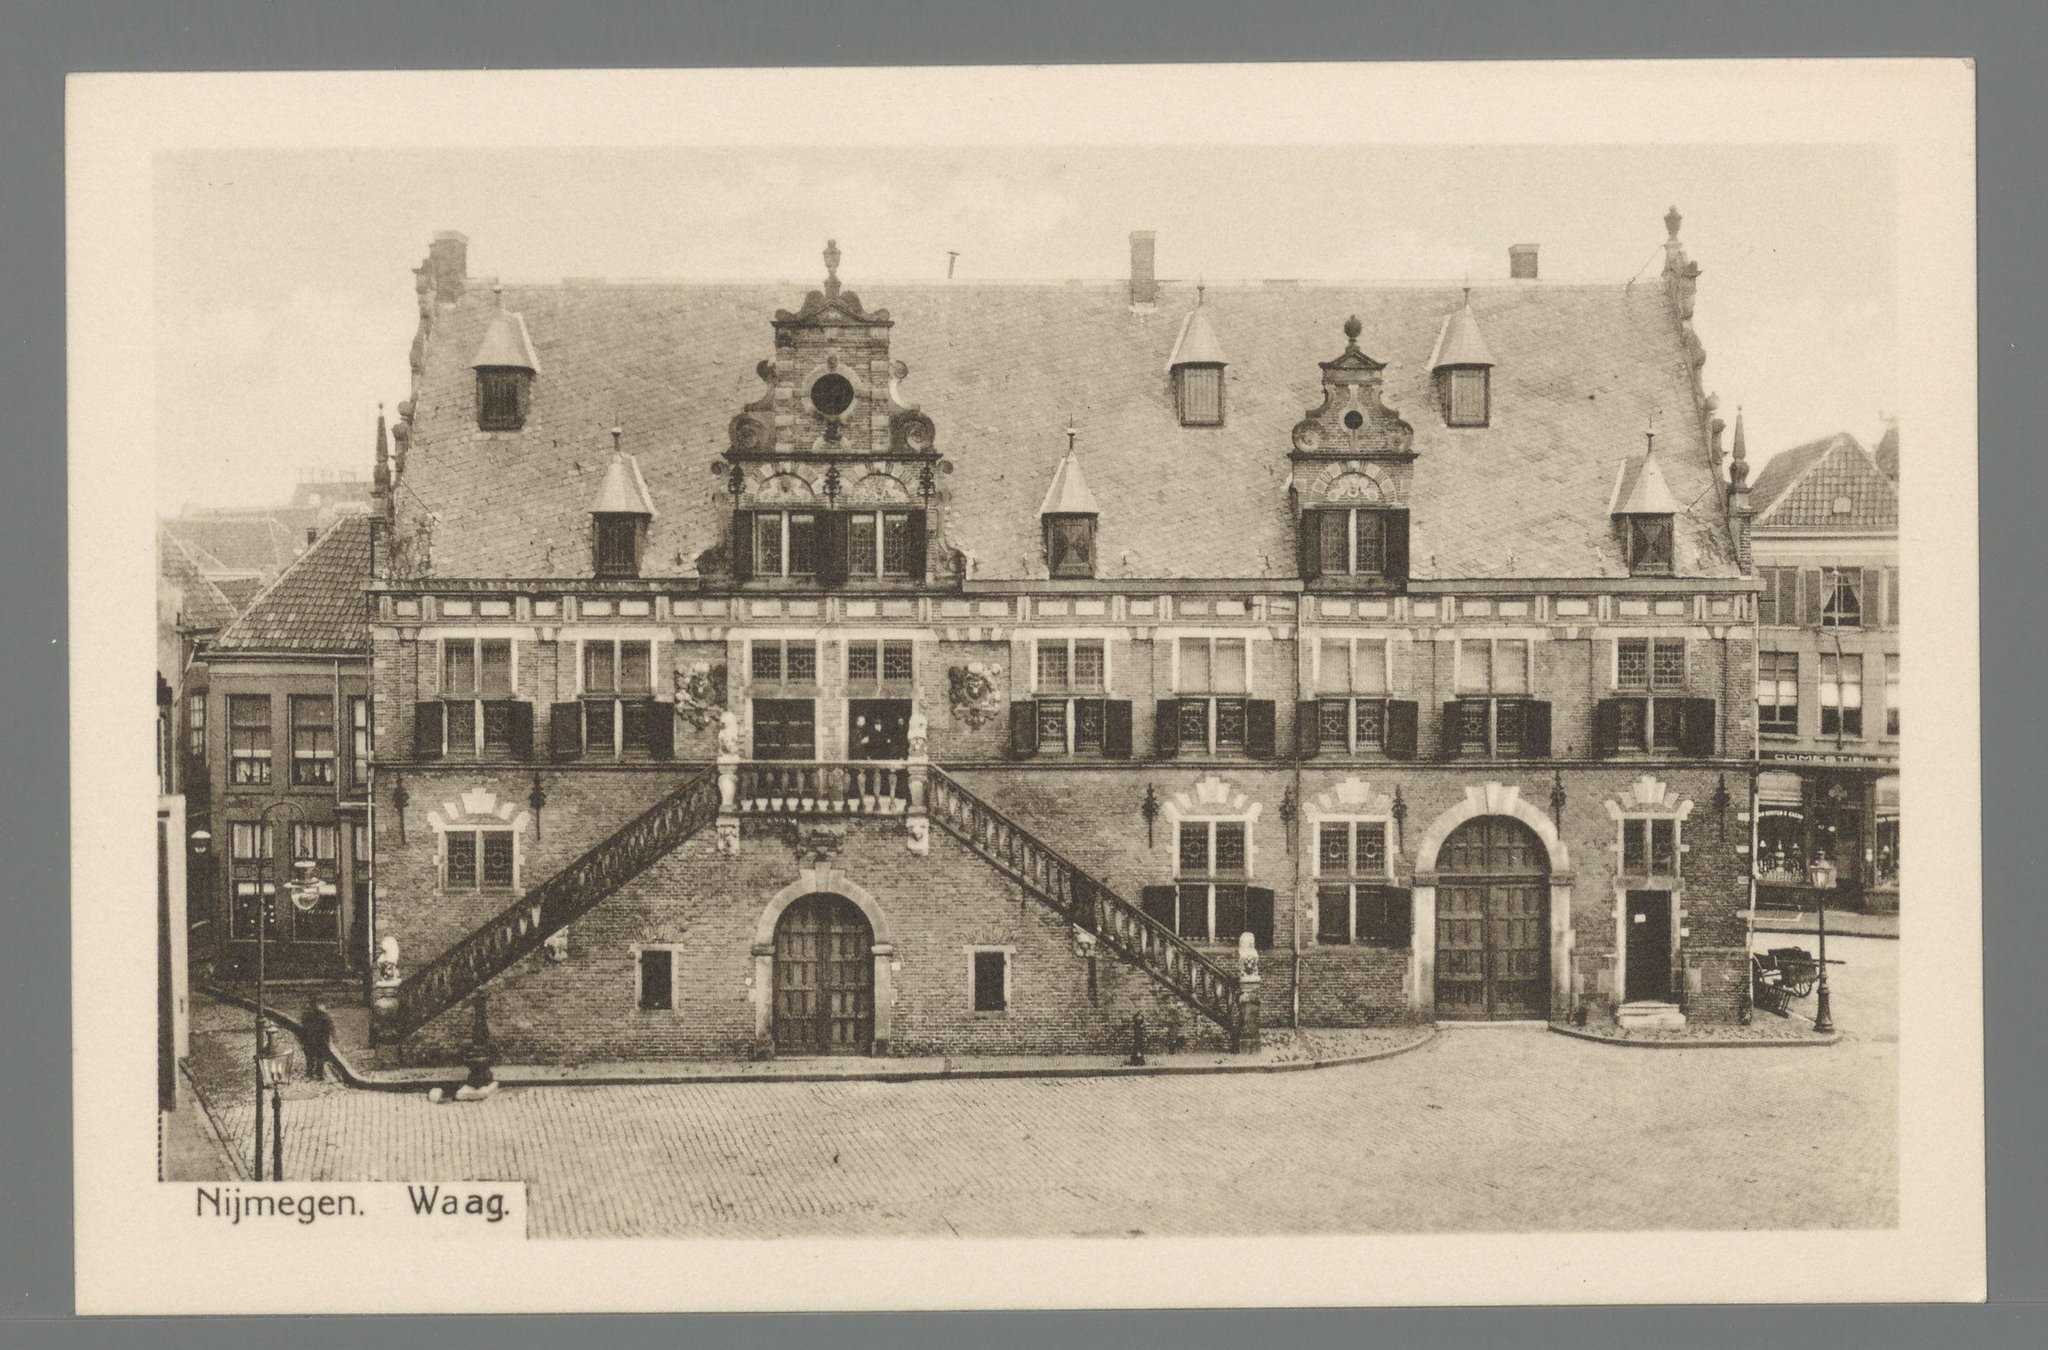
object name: ansichtkaart, prentbriefkaart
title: Nijmegen. Waag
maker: Anonymous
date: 1914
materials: cardboard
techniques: photograph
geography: nijmegen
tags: square, place, circus, etc., weigh-house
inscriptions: date